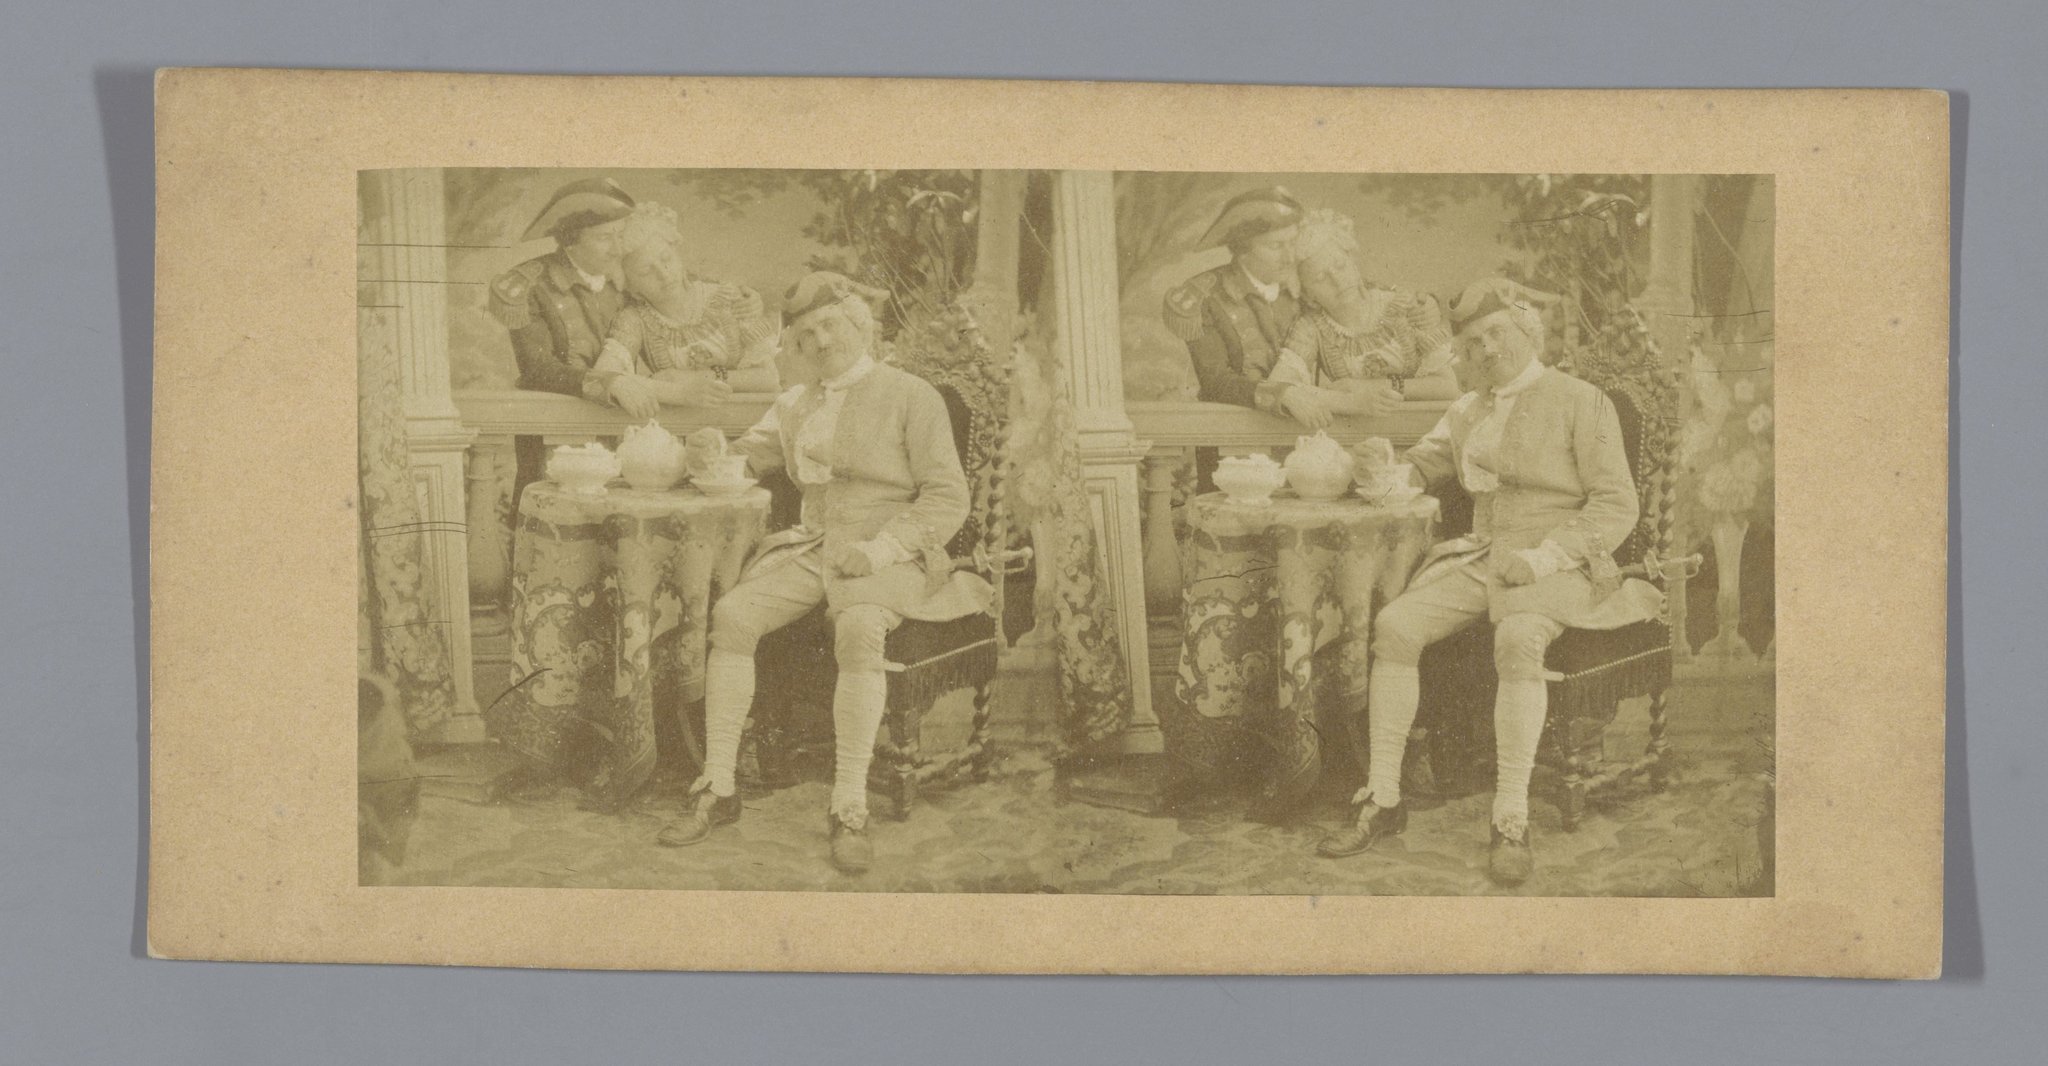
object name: stereograph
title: Theatrale voorstelling van een man in een historisch kostuum aan tafel, op de achtergrond leunt een paartje over een hek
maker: Anonymous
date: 1850-1880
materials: cardboard, photographic support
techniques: albumen print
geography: europe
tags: historical costume, summer-house, arbour, garden-house (dutch: 'theekoepel'), europe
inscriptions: number: ‘11891’